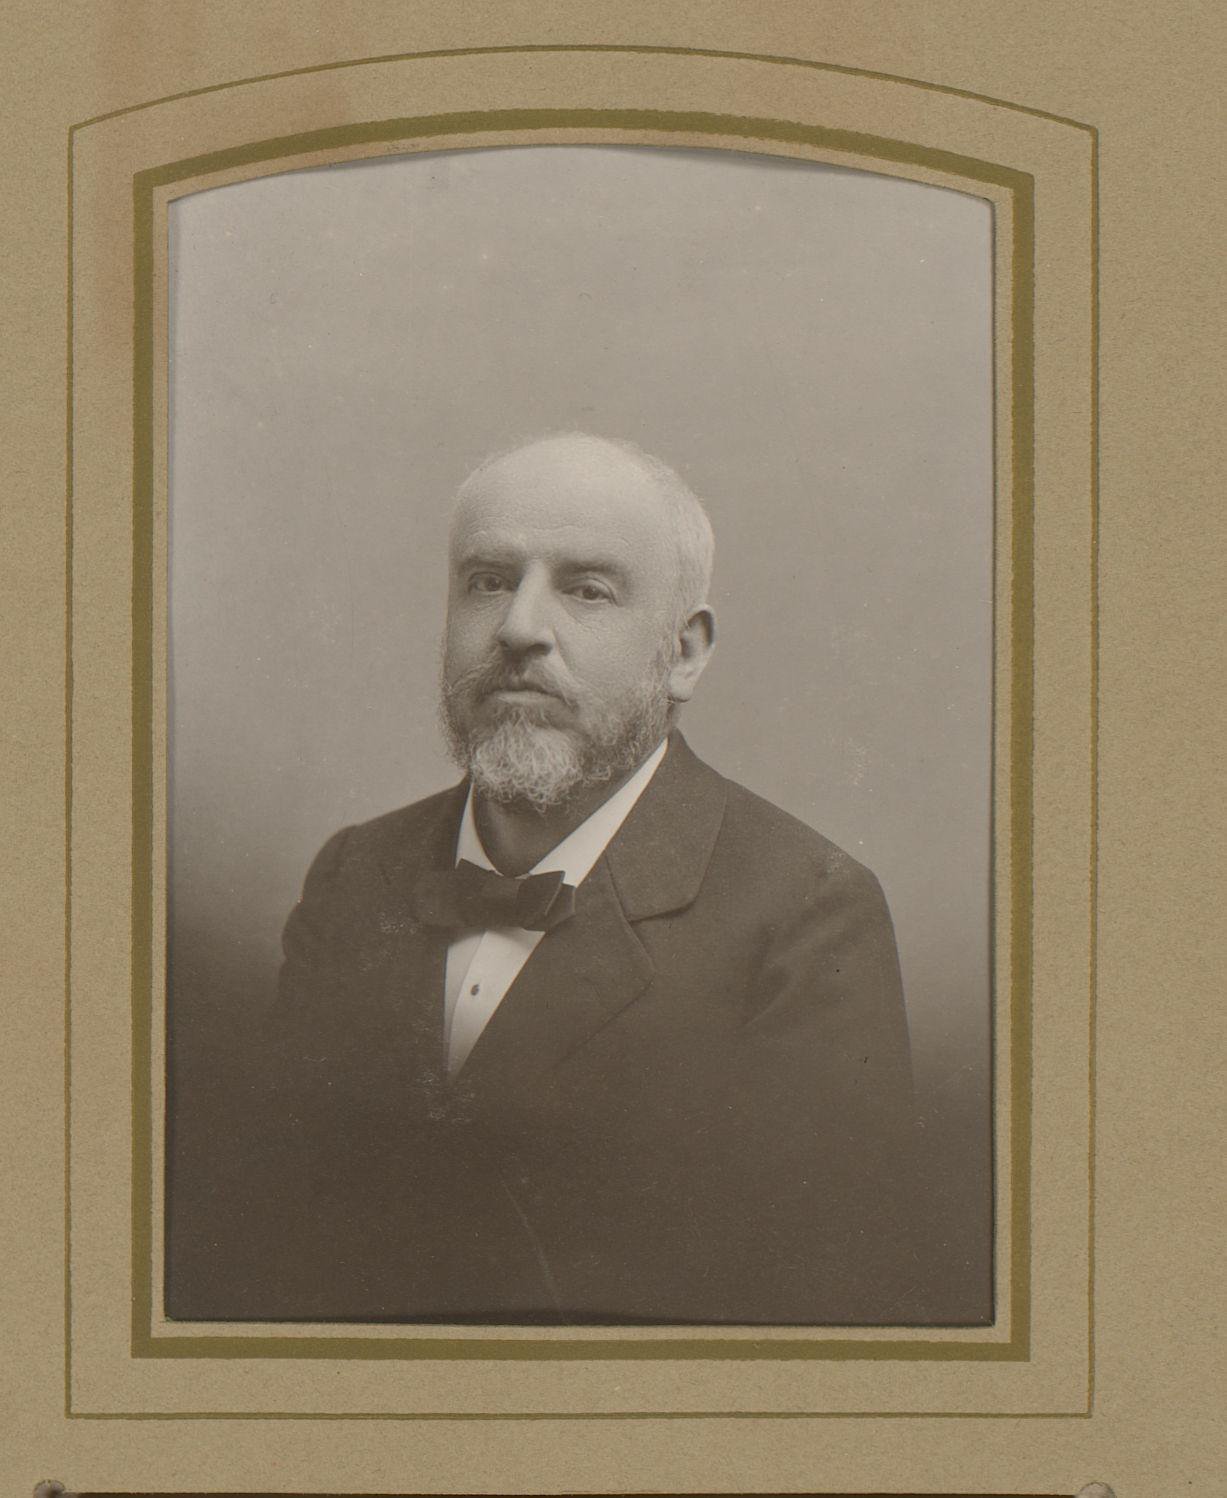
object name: album leaf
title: Portret van een man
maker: Anonymous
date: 1895-1920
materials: cardboard, photographic support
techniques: matte daylight collodion silver print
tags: historical persons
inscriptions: annotation: ‘B’